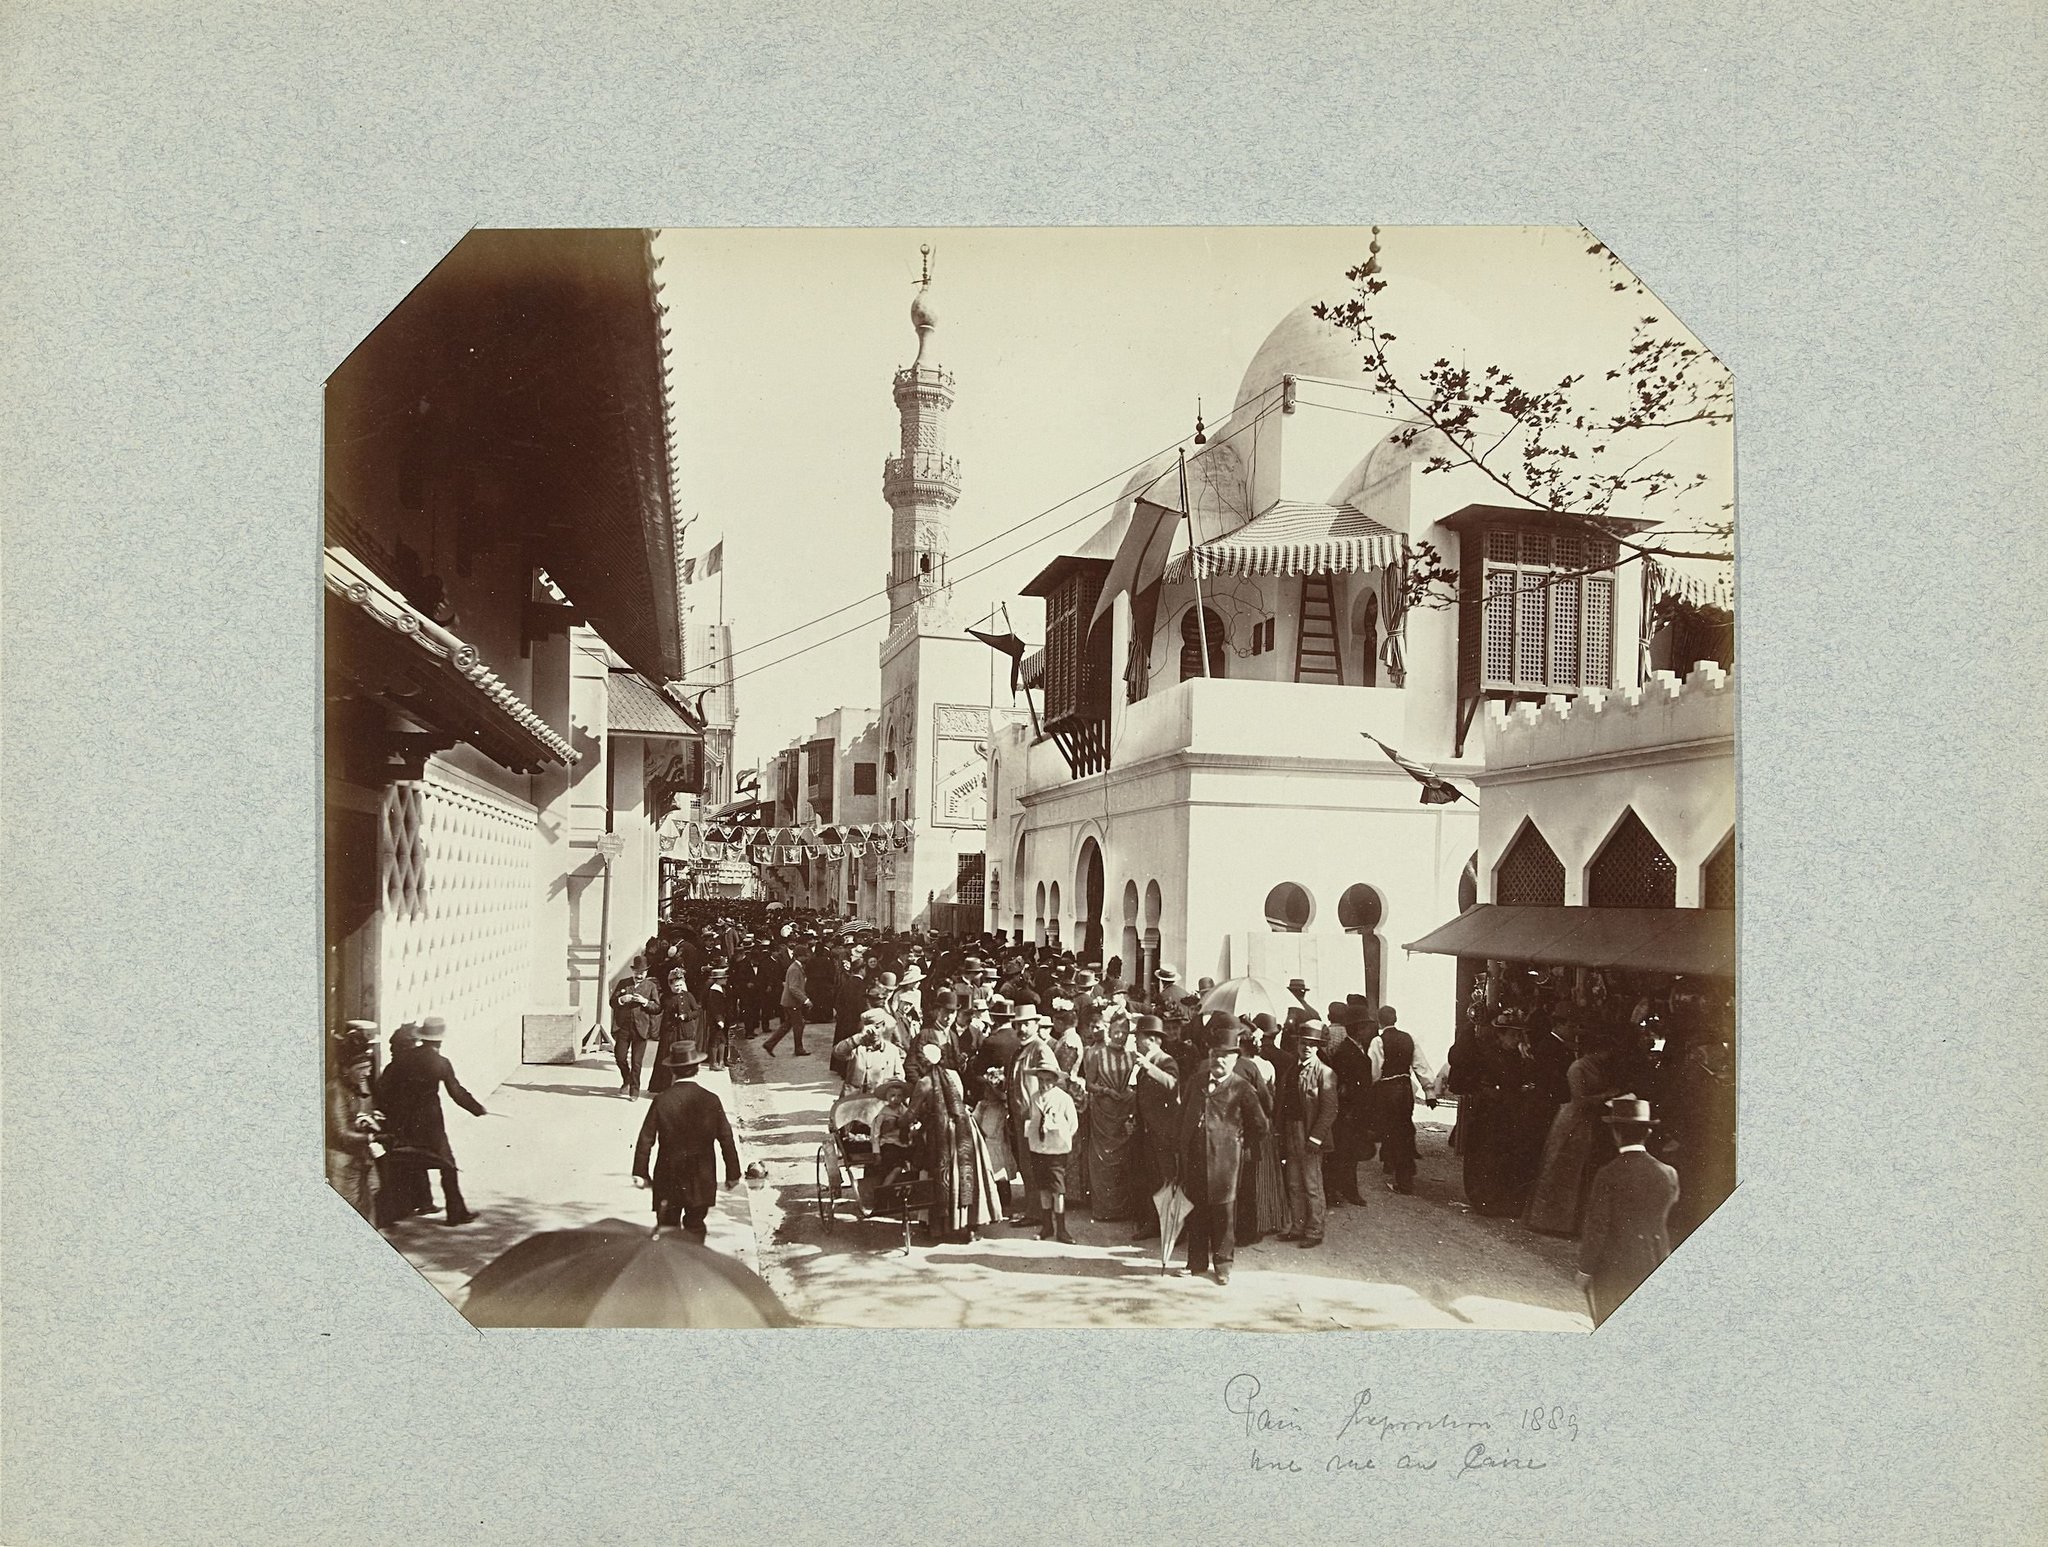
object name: photograph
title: Rue de Caire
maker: Anonymous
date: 1889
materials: cardboard, paper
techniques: albumen print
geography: paris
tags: world fair, world exhibition, street, paris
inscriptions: stamp: ‘14’, inscription: ‘Paris Exposition 1889/ Vue rue de Caire’